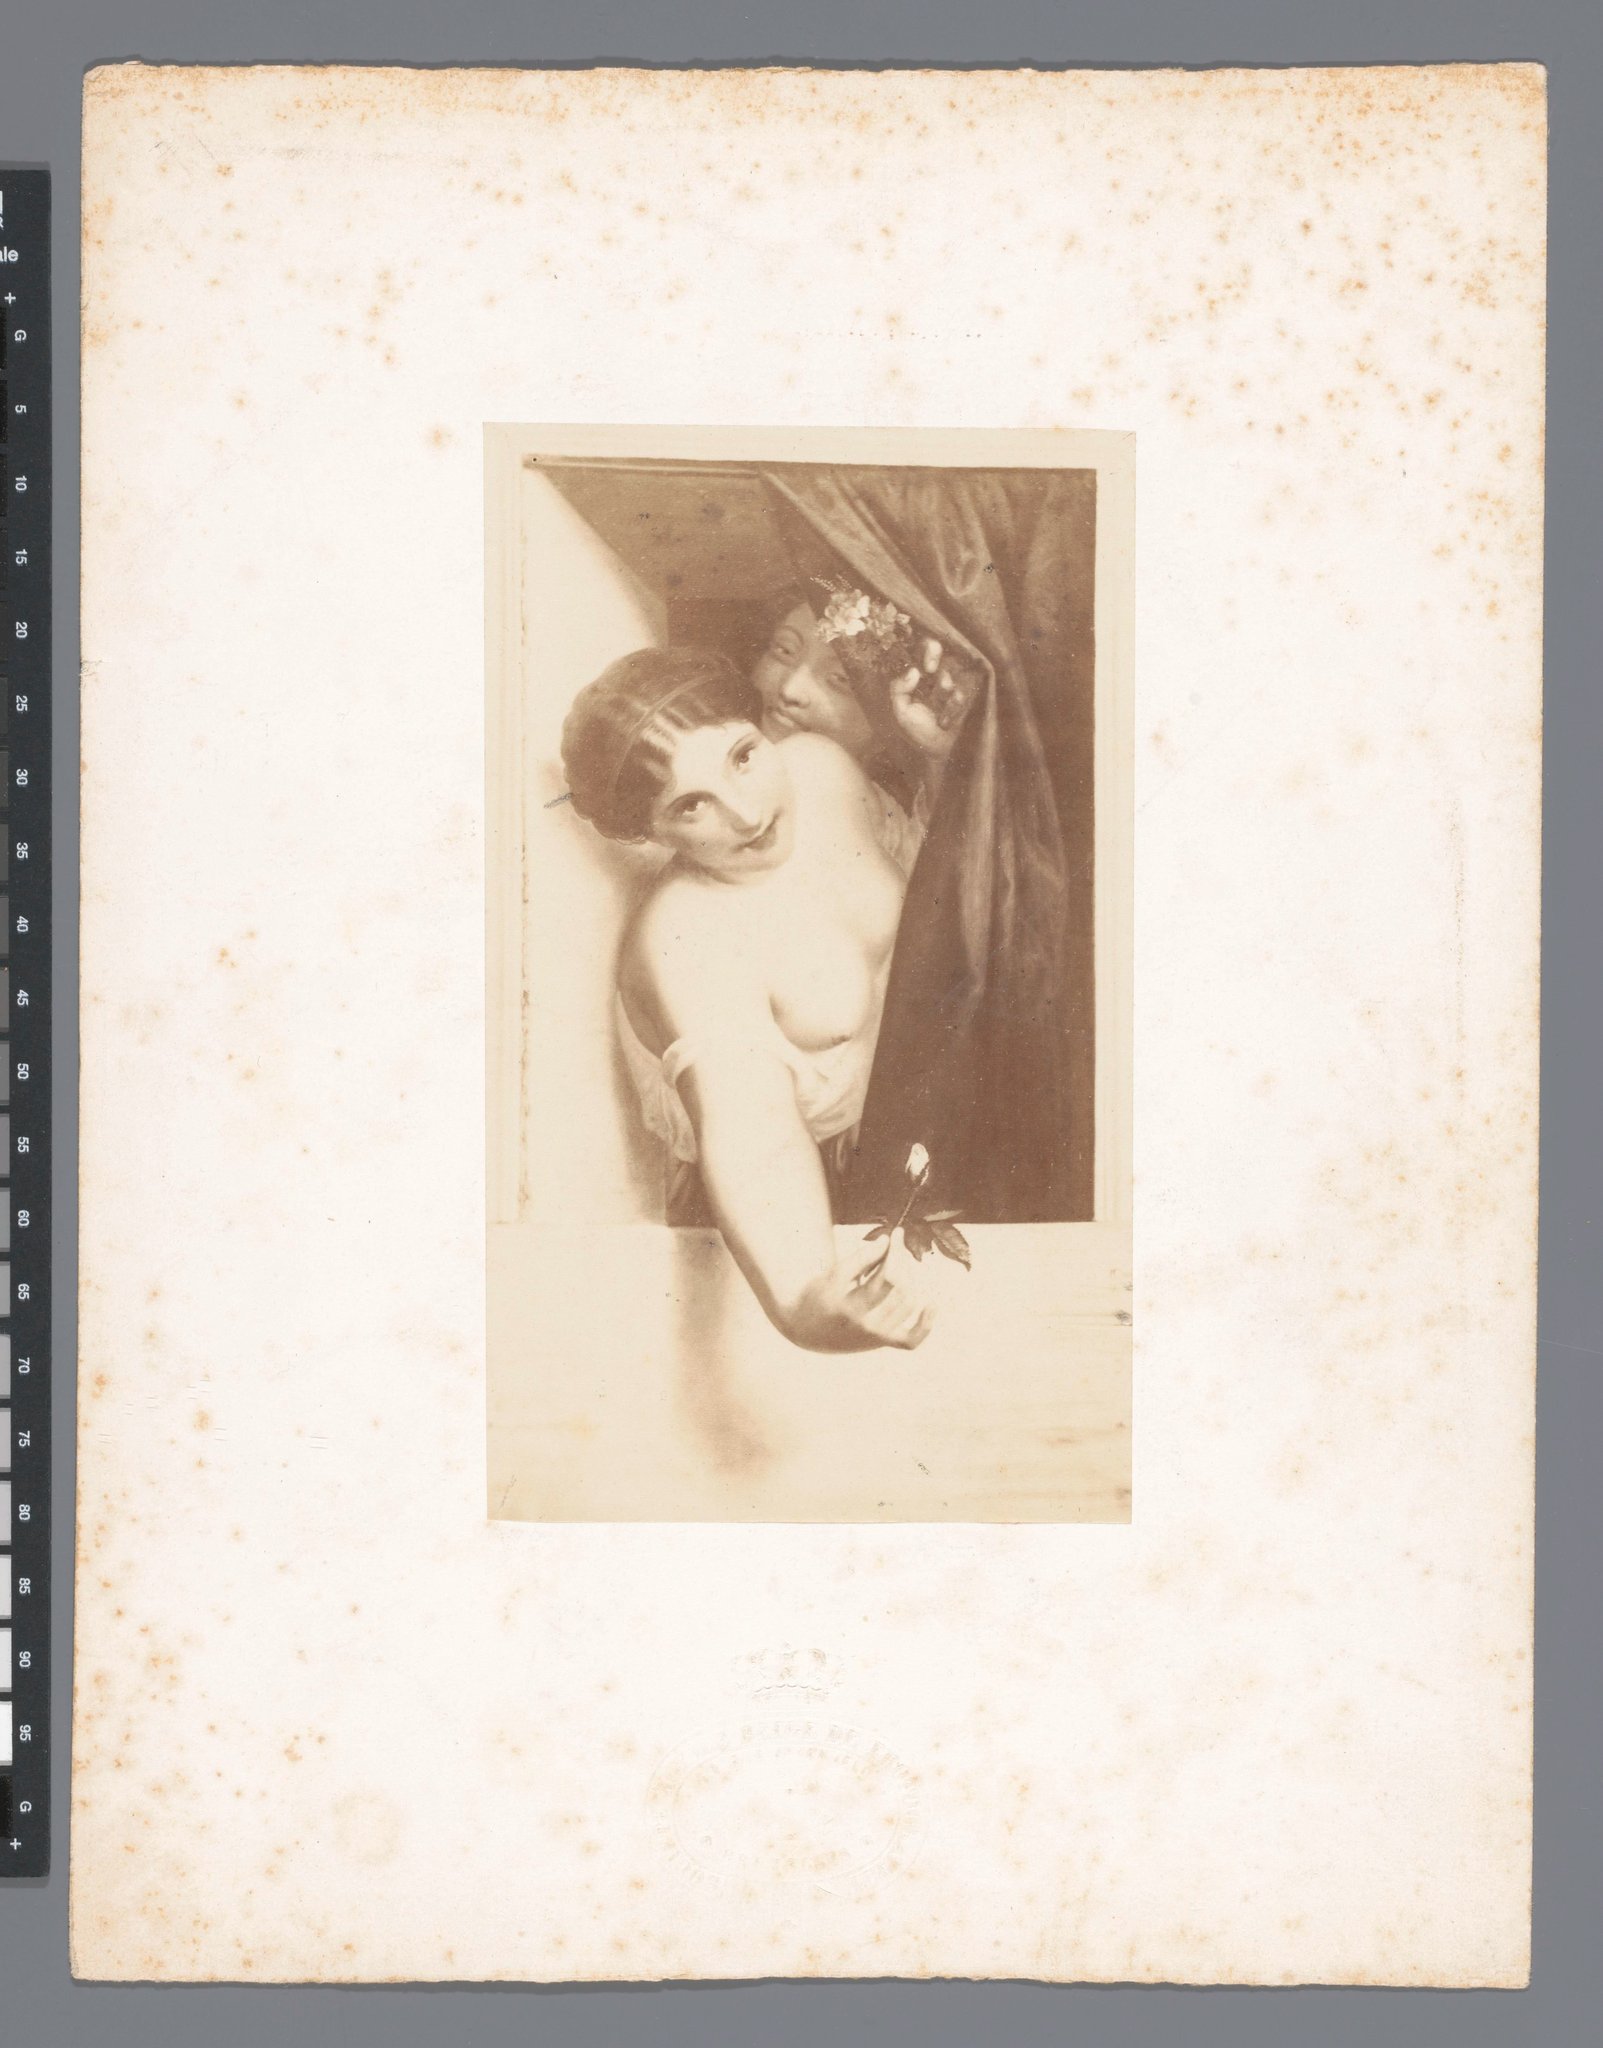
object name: reproduction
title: Fotoreproductie van een schilderij van een naakte vrouw met bloemen achter een gordijn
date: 1863-1893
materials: cardboard, paper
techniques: albumen print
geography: brussels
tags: curtains, woman (showing herself) undressed, quasi-nude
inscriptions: inscription: ‘SOCIÉTÉ ROYALE BELGE DE PHOTOGRAPHIE/ 69 RUE KEYENVELD/ BRUXELLES’